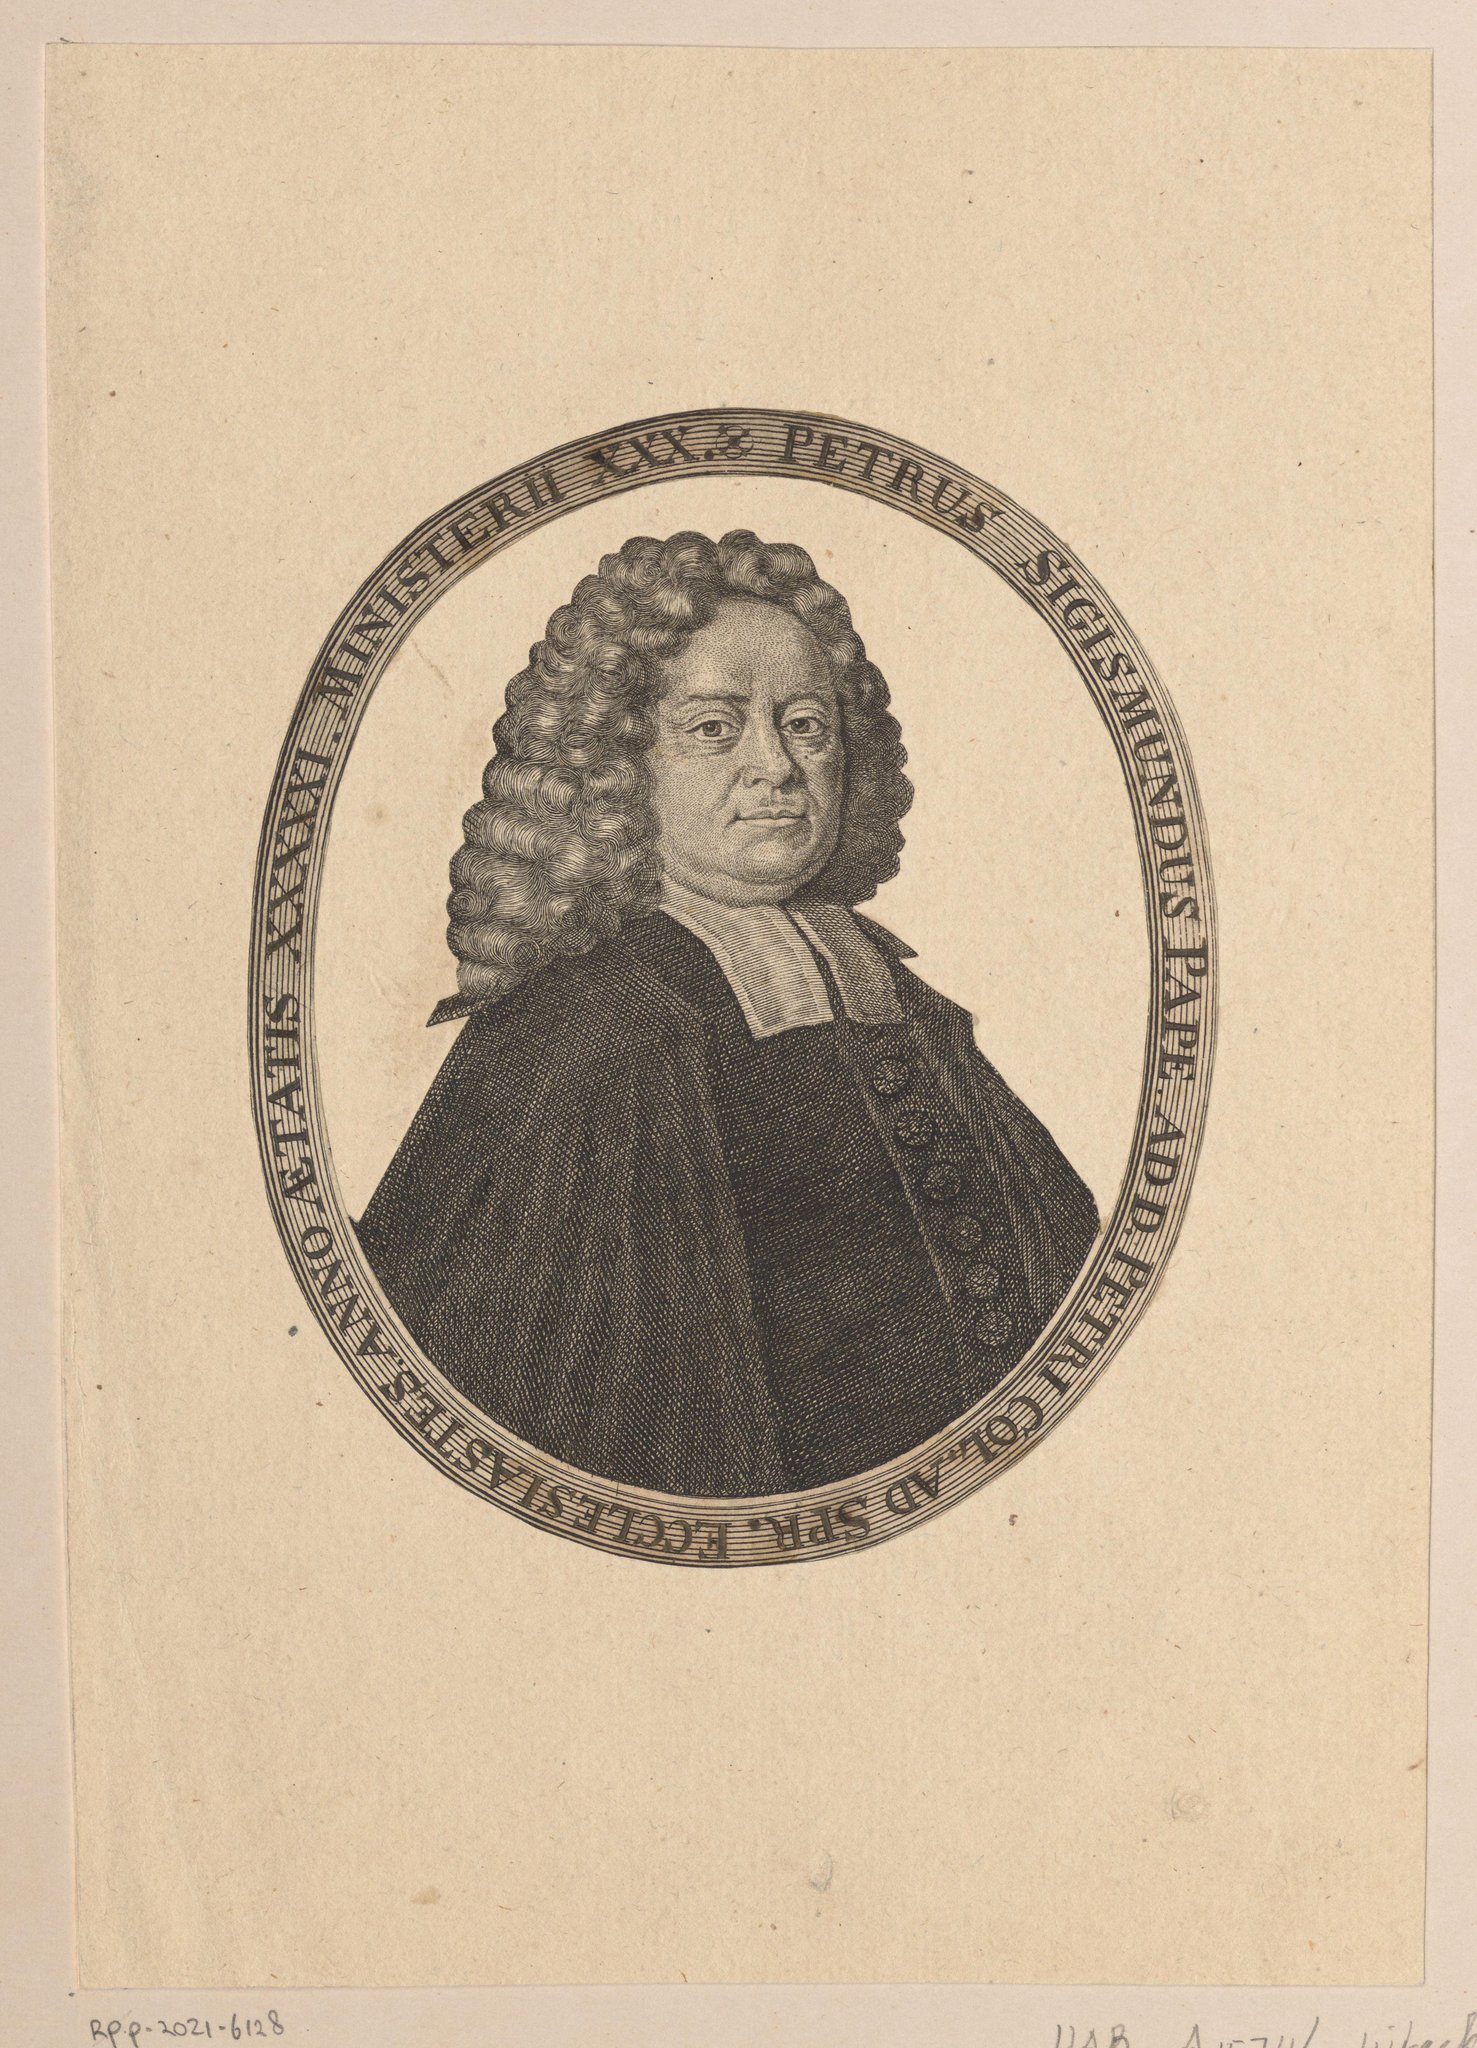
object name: print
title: Portret van Peter Sigismund Pape op 51-jarige leeftijd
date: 1717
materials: paper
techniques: engraving, hand coloring, snipping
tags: adult man, historical persons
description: Het portret is uitgeknipt en geplakt op een ander blad.